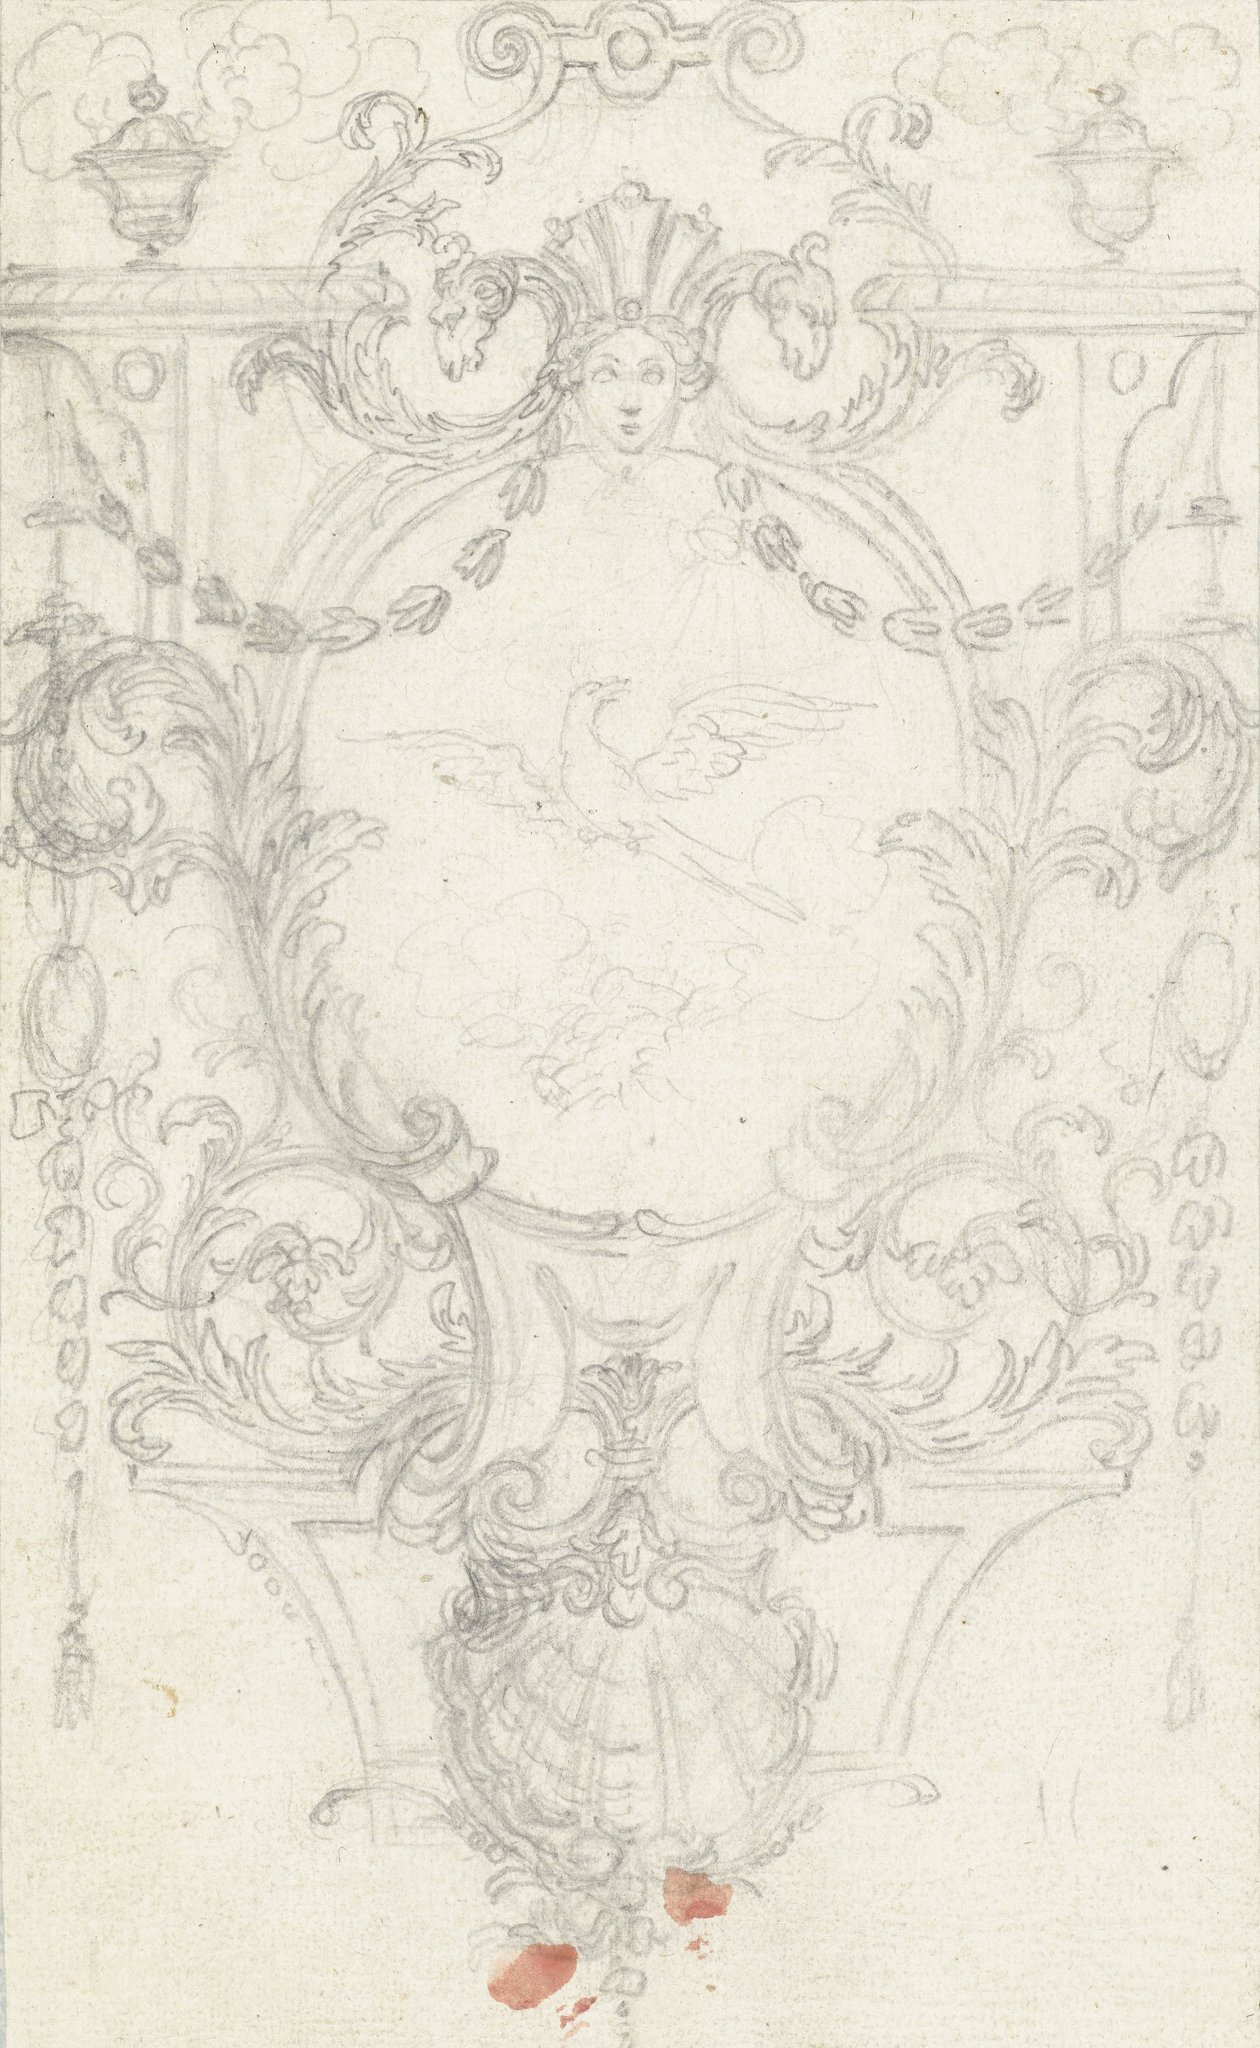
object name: drawing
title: Paneelvulling met een vliegende vogel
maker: bernard picart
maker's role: draughtsman, print maker, publisher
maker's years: 1673-1733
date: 1683-1733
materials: paper, pencil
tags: ornaments ~ art